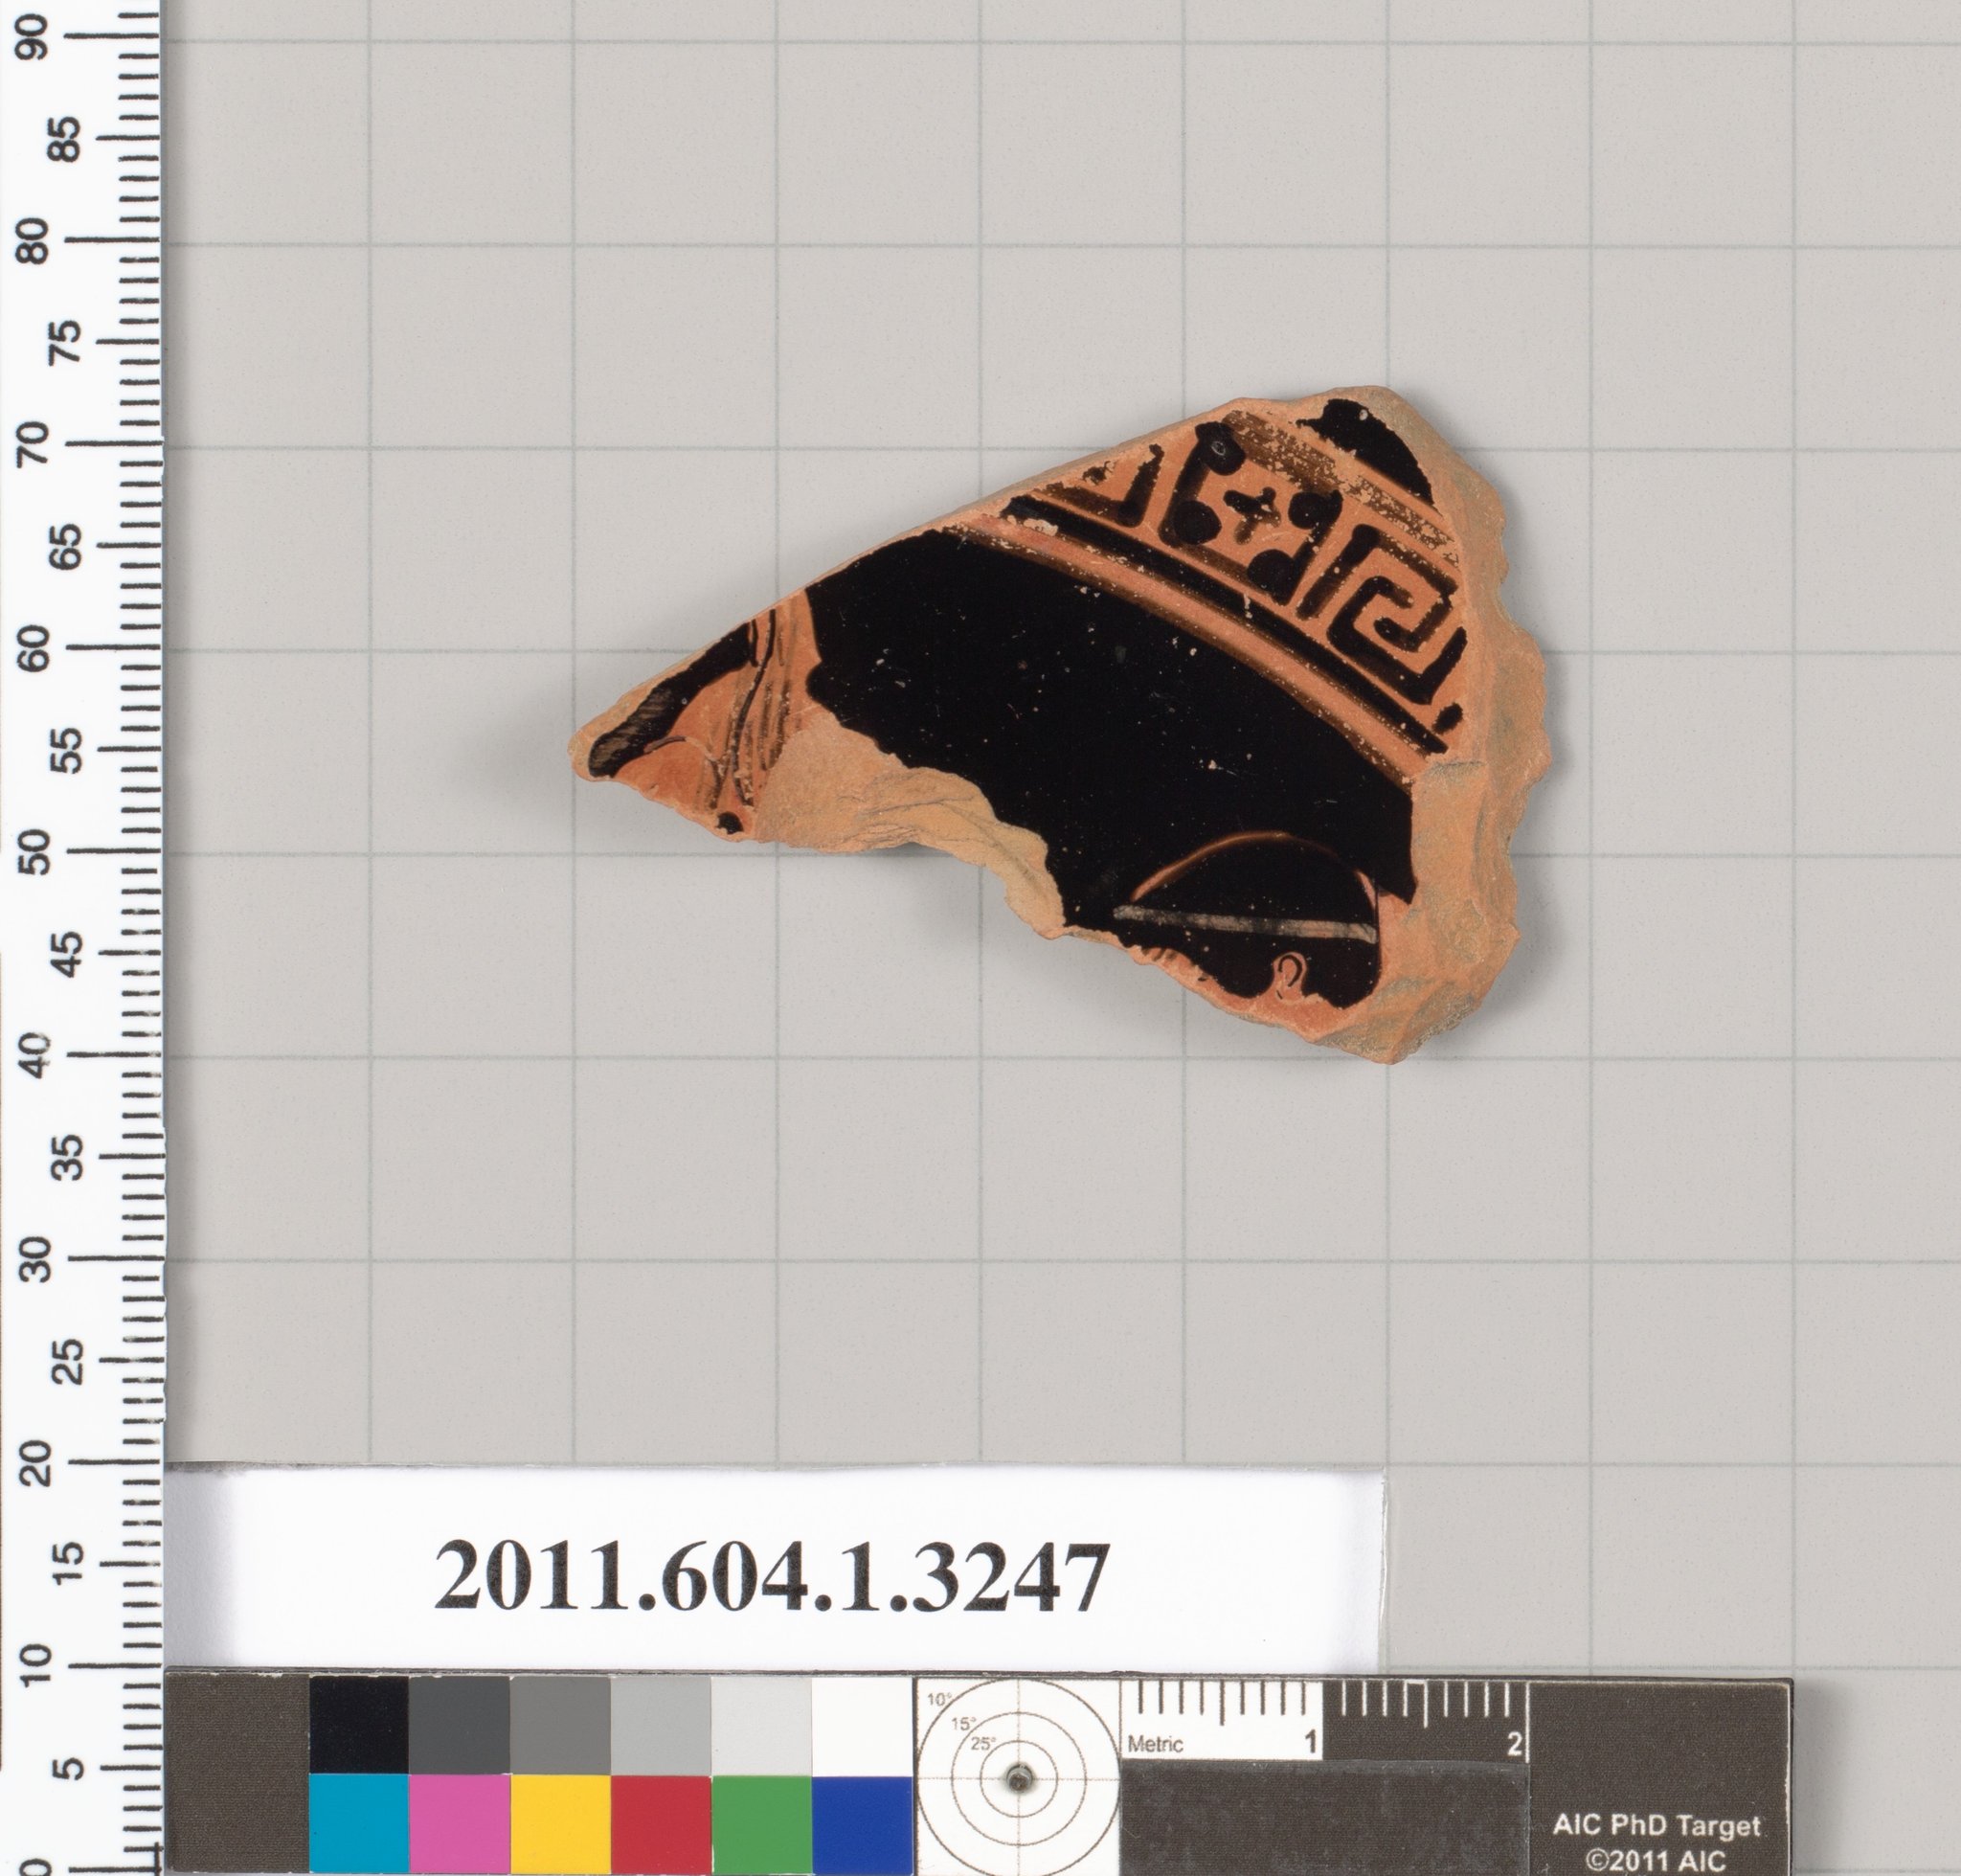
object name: kylix fragment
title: Terracotta fragment of a kylix (drinking cup)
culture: greek, attic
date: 490-480 BCE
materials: terracotta